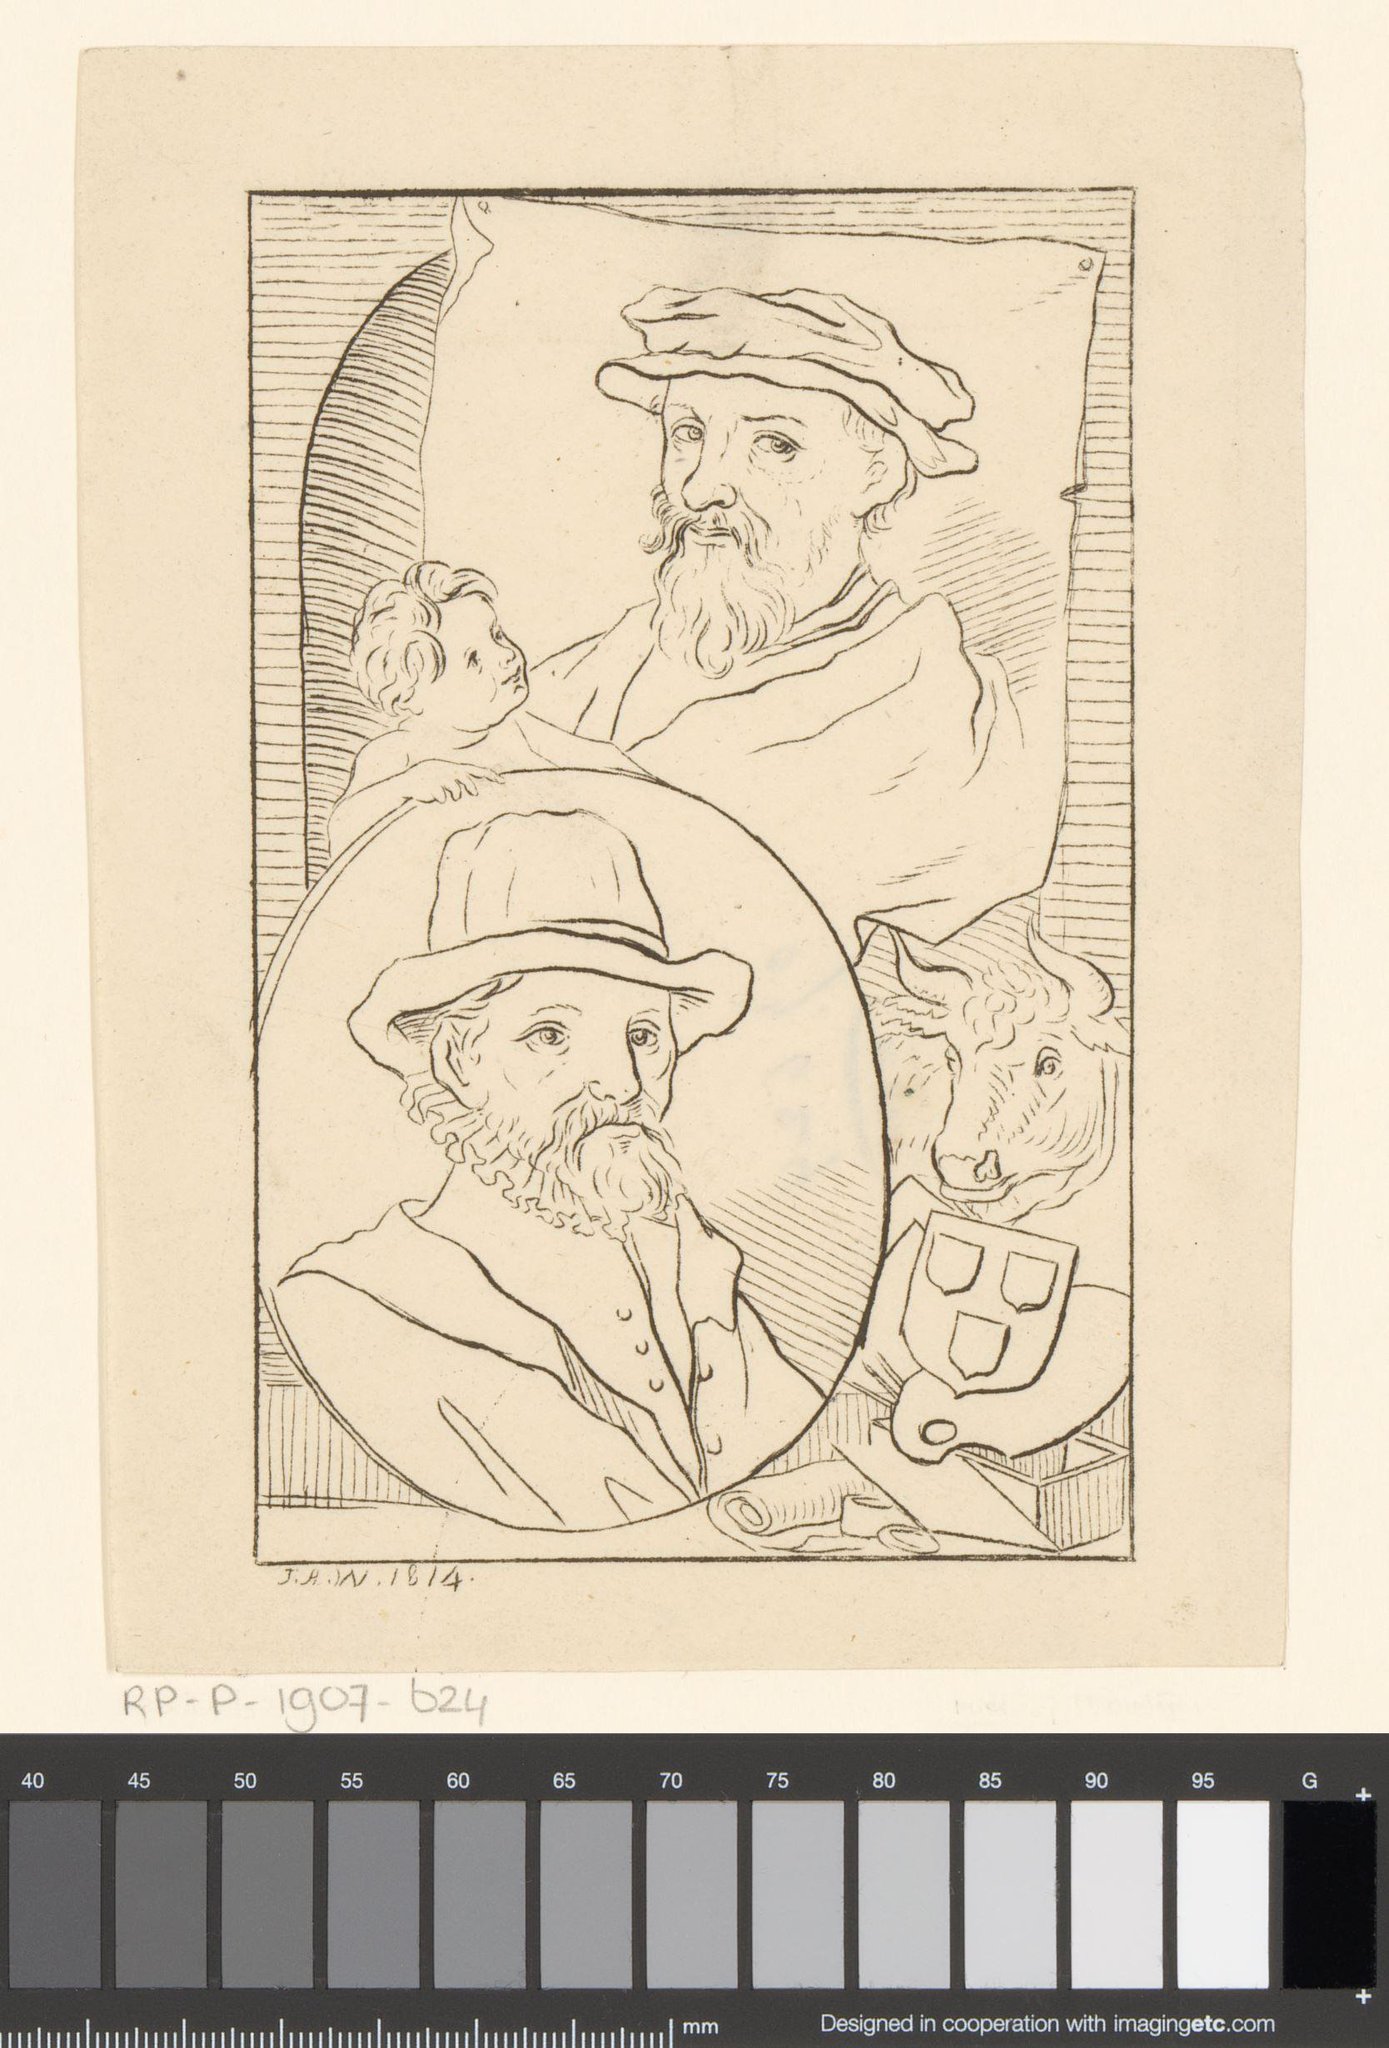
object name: print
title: Portretten van Dirck en Wouter Pietersz. Crabeth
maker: jacobus adrianus weiland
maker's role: print maker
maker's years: 1784-1869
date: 1814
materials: paper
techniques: lithograph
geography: netherlands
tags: gouda, draughtsman, dirck pietersz. crabeth, designer, wouter pietersz i crabeth, historical persons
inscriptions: collector's mark: Lugt 2228